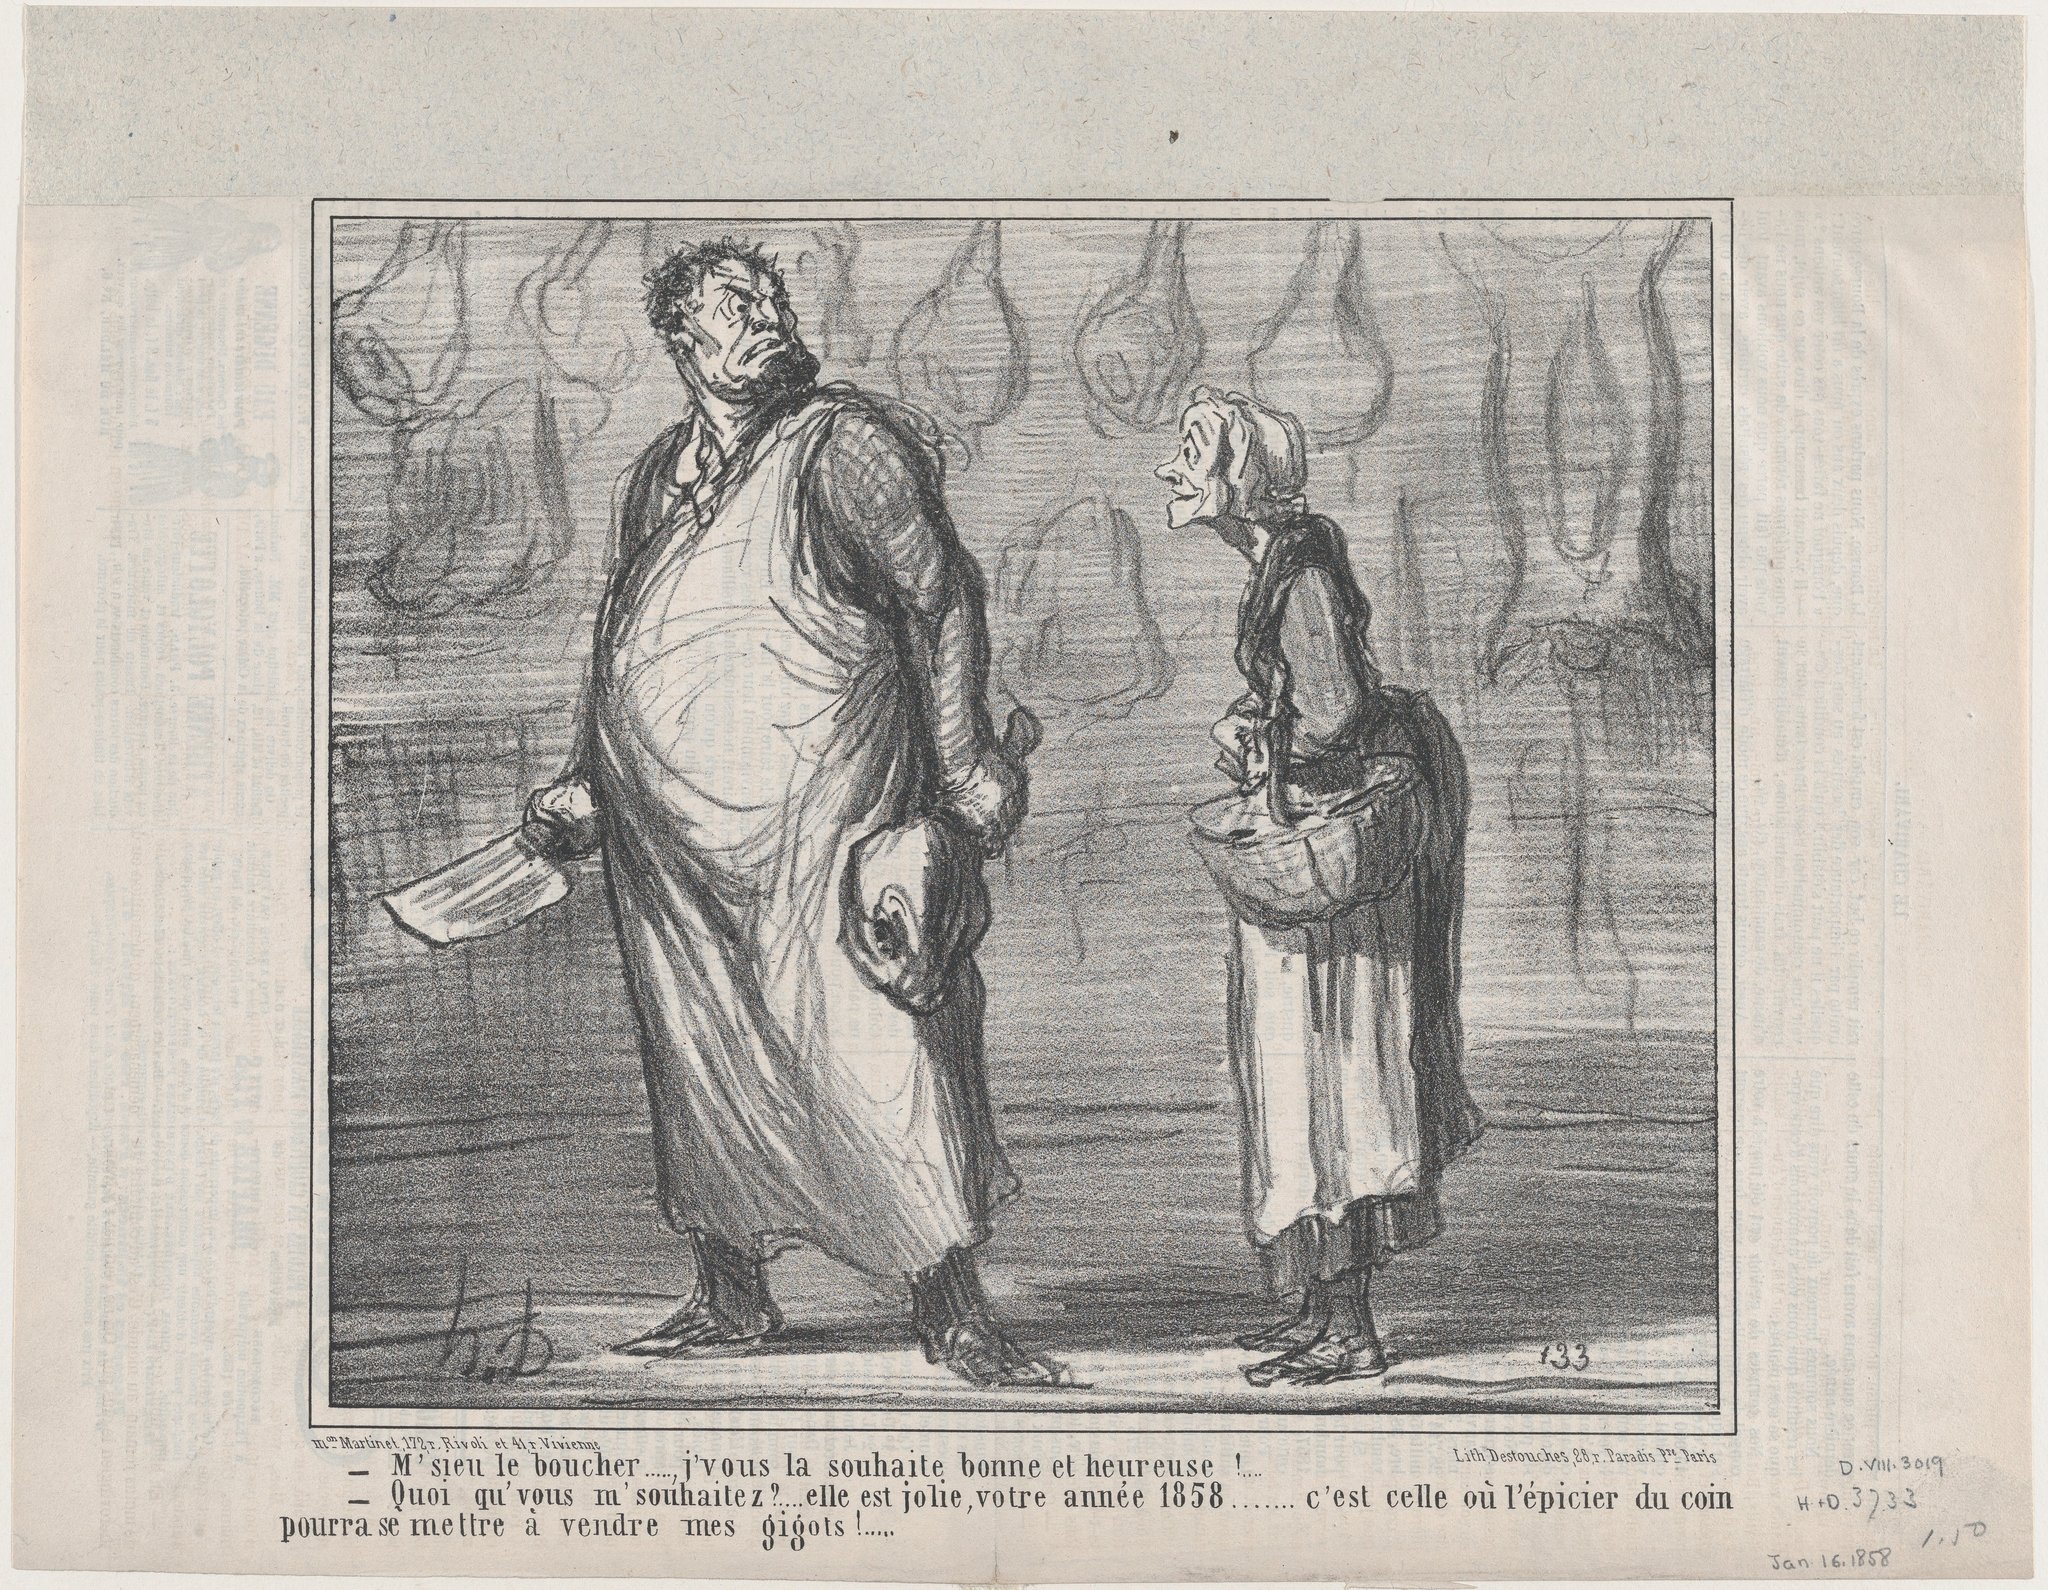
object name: print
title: M'sieu le boucher..., j'vous la souhaite bonne et heureuse!, from "Actualités"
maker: honoré daumier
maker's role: artist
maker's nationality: french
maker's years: 1808-1879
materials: paper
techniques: lithograph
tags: satire,men,women,butchers